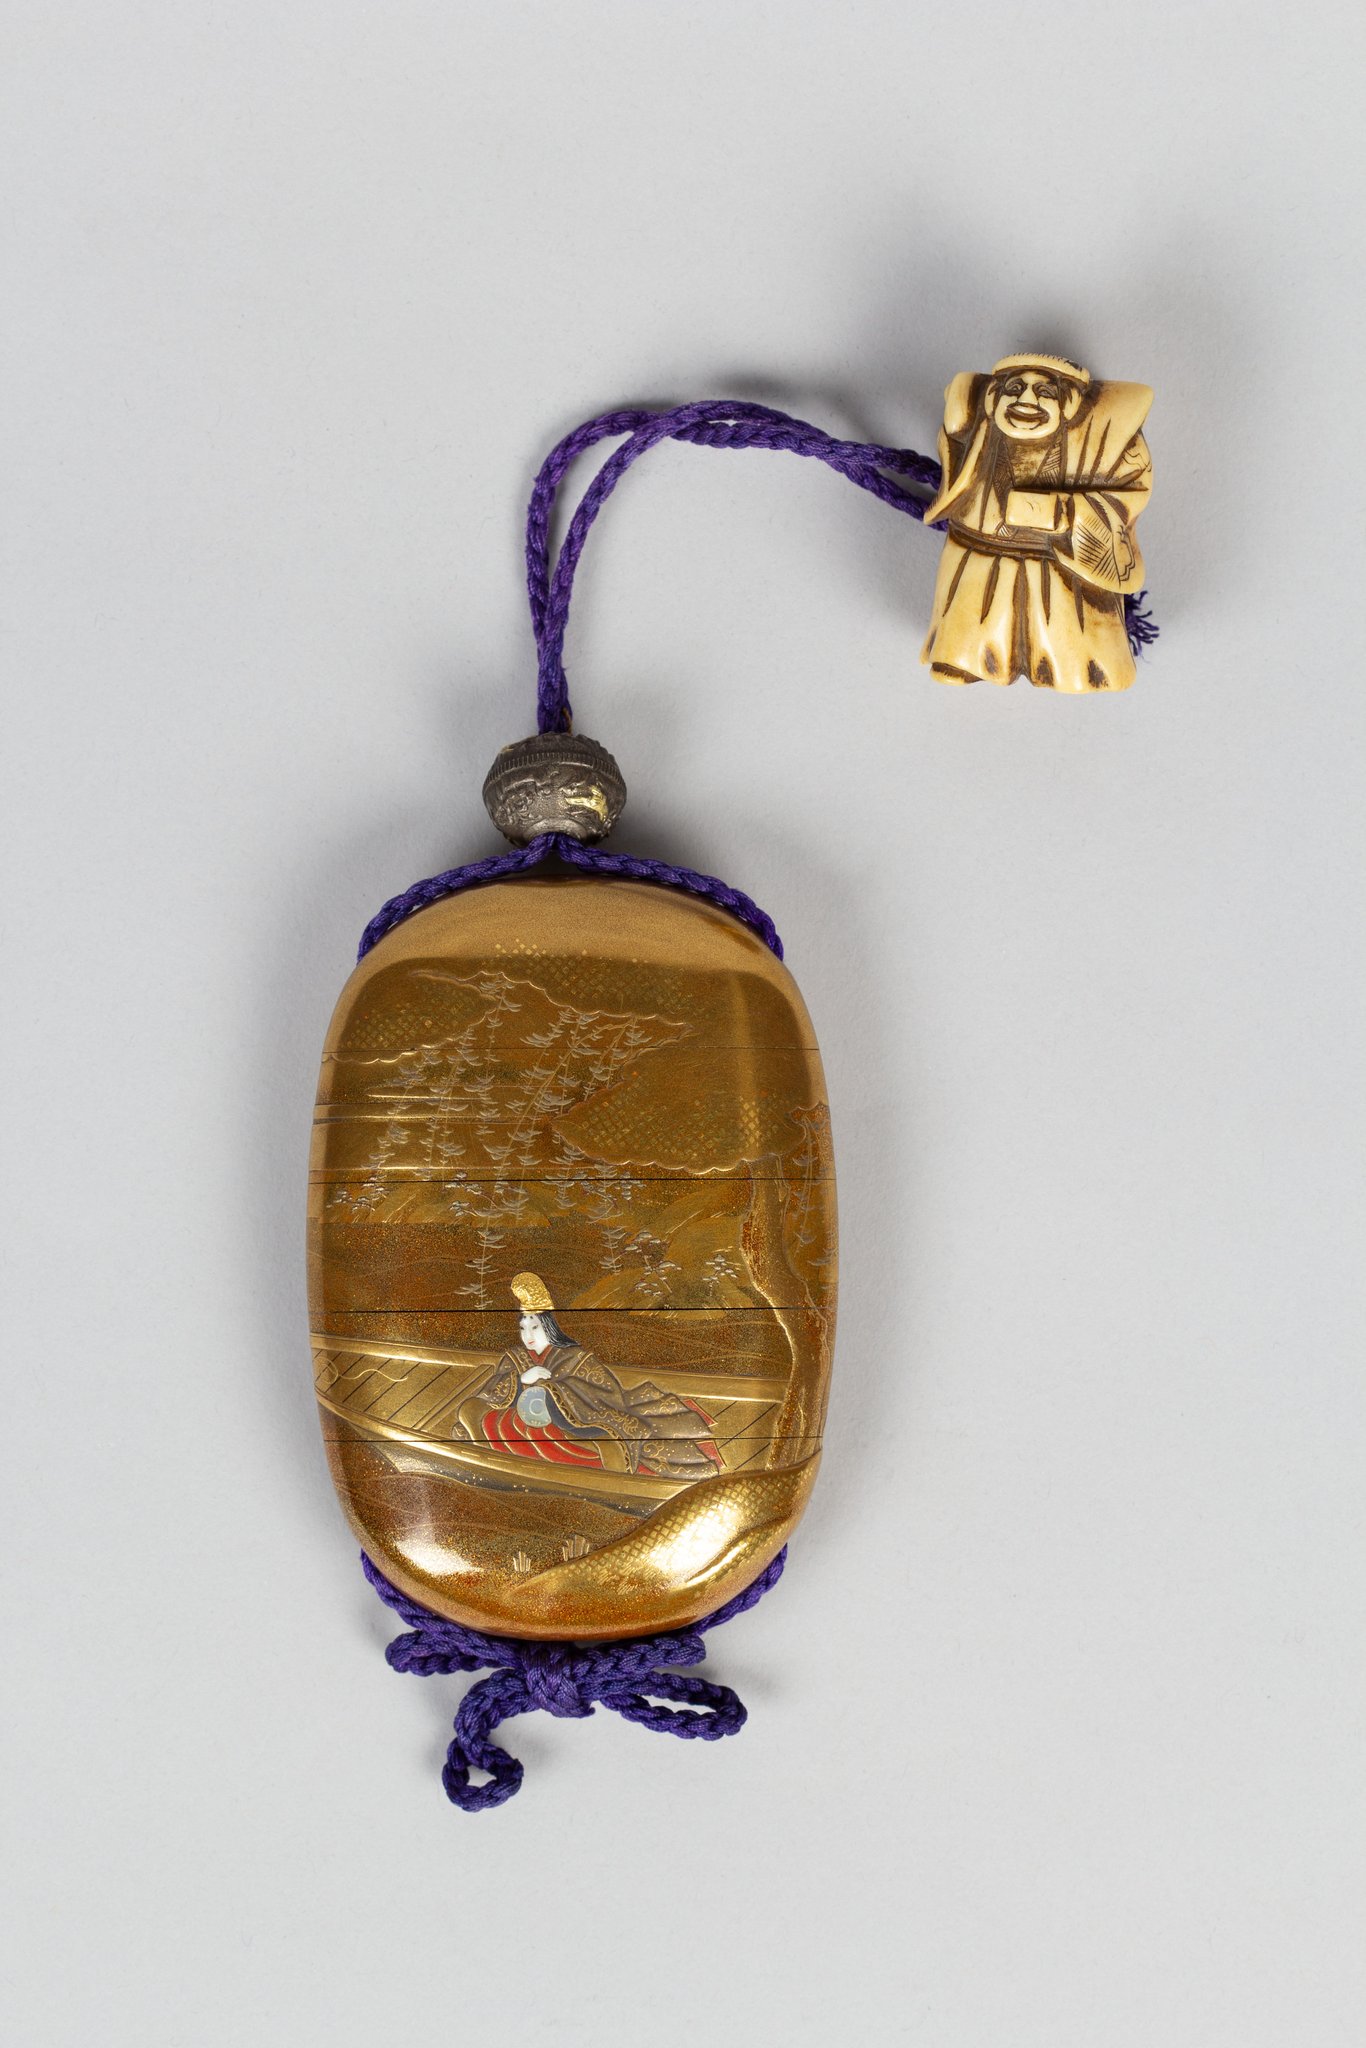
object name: inrō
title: Case (Inrō) with Design of Court Lady in Boat with Drum (obverse); Geese Taking Flight (reverse)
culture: japanese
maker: shibayama shokasai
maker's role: artist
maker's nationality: japanese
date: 1801-1900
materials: gold, ivory, lacquer, metal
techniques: hiramakie, inlay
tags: birds,women,mountains,boats